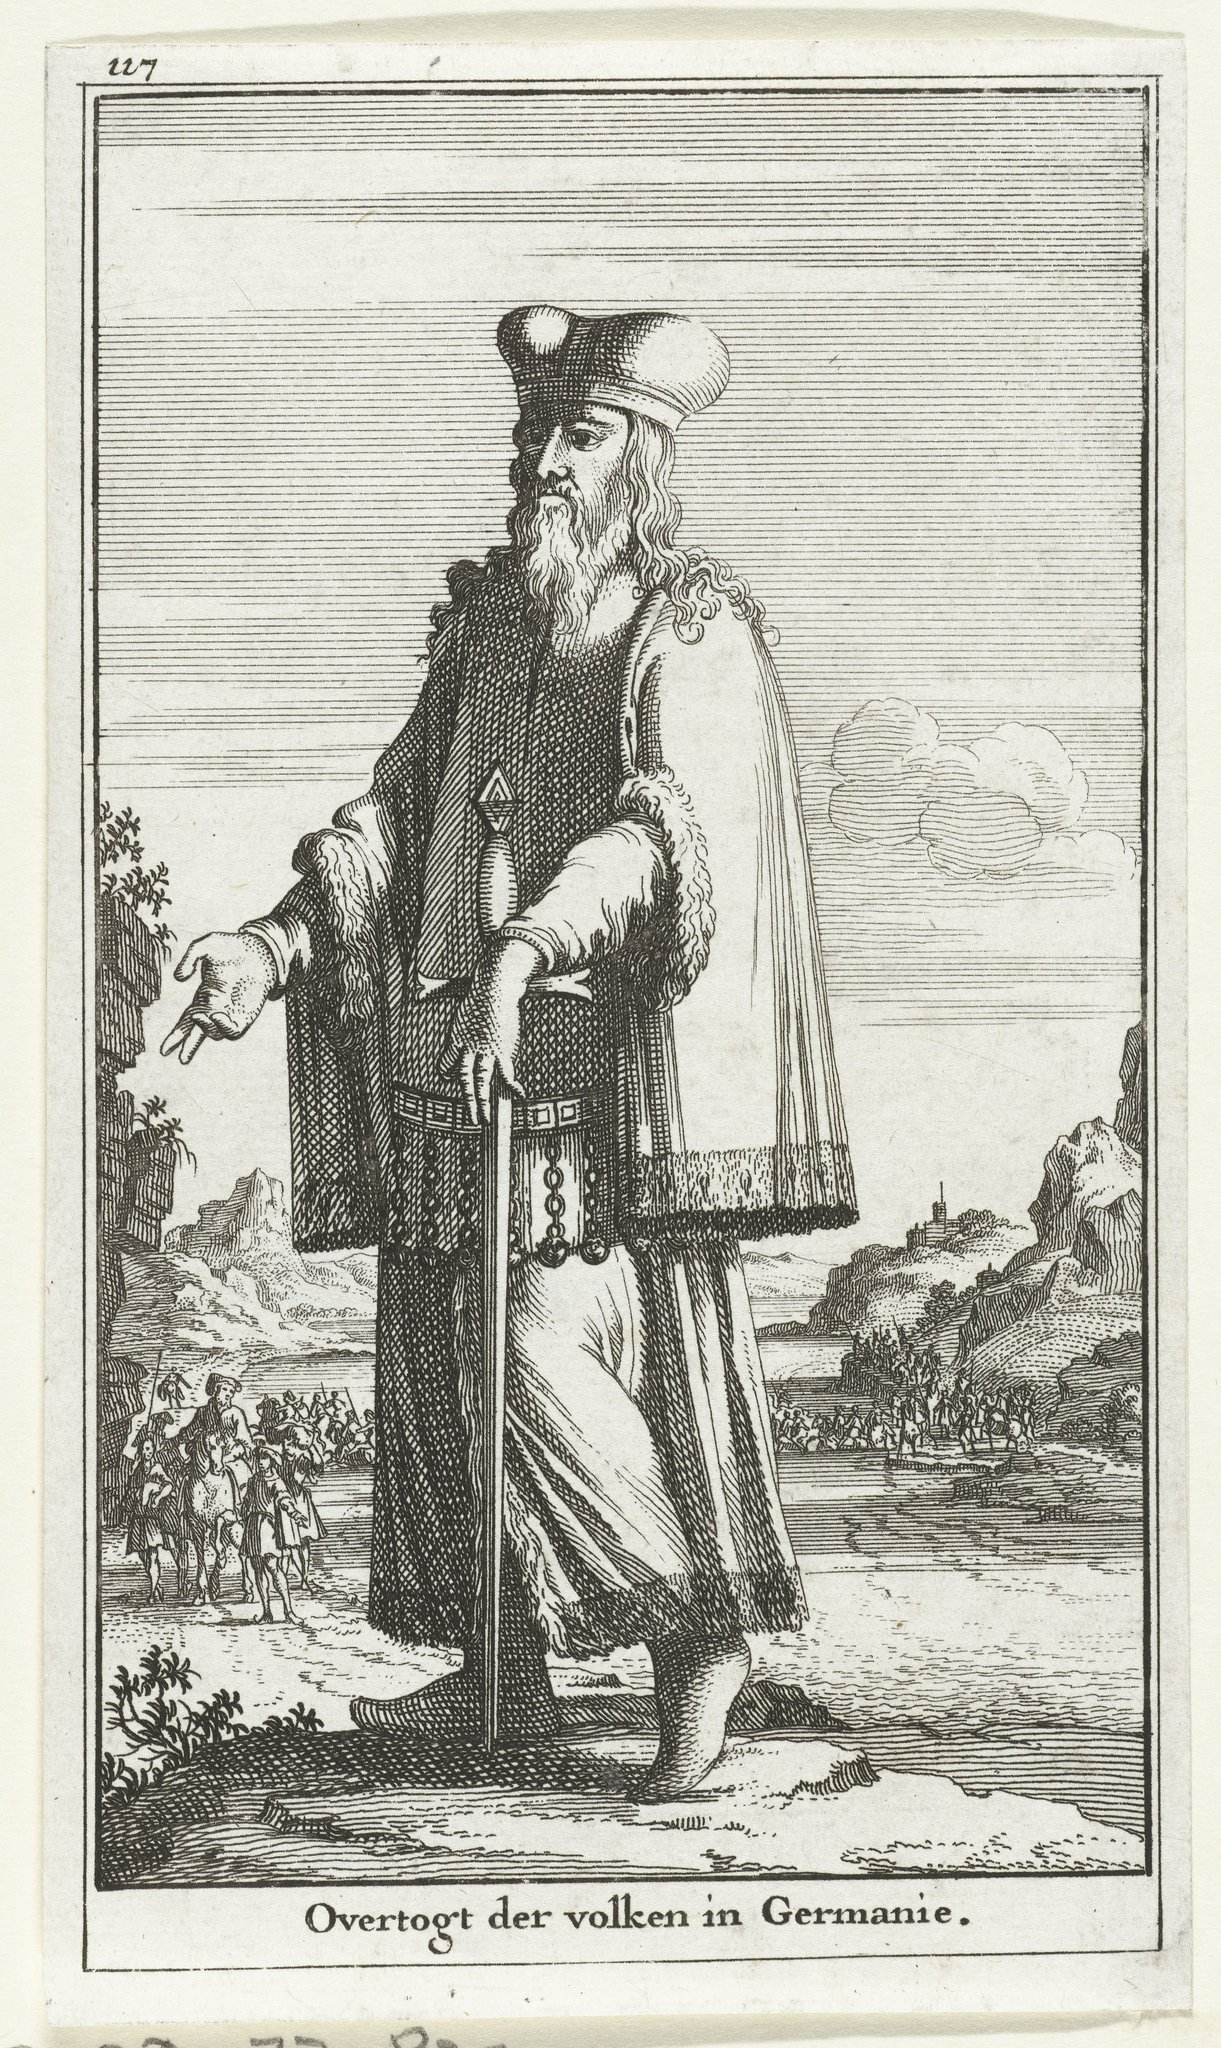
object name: print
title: Volksverhuizing bij de Germanen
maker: Anonymous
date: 1712-1714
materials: paper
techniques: etching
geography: netherlands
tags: extinct, 'historical' peoples (with name), netherlands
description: Gebruikt als illustratie in: Hugo de Groots Antiquitates Germanicæ, of Hoogduitsche oudtheden: waar in de gelegentheid en zeeden der Germaanen, beschreeven door Tacitus, naaukeurig verklaart, en met printverbeeldingen opgeheldert worden: benevens H. Grotius verhandeling van de oudtheid der Batavische republyk. Amsterdam: Jacob van Royen, 1714.